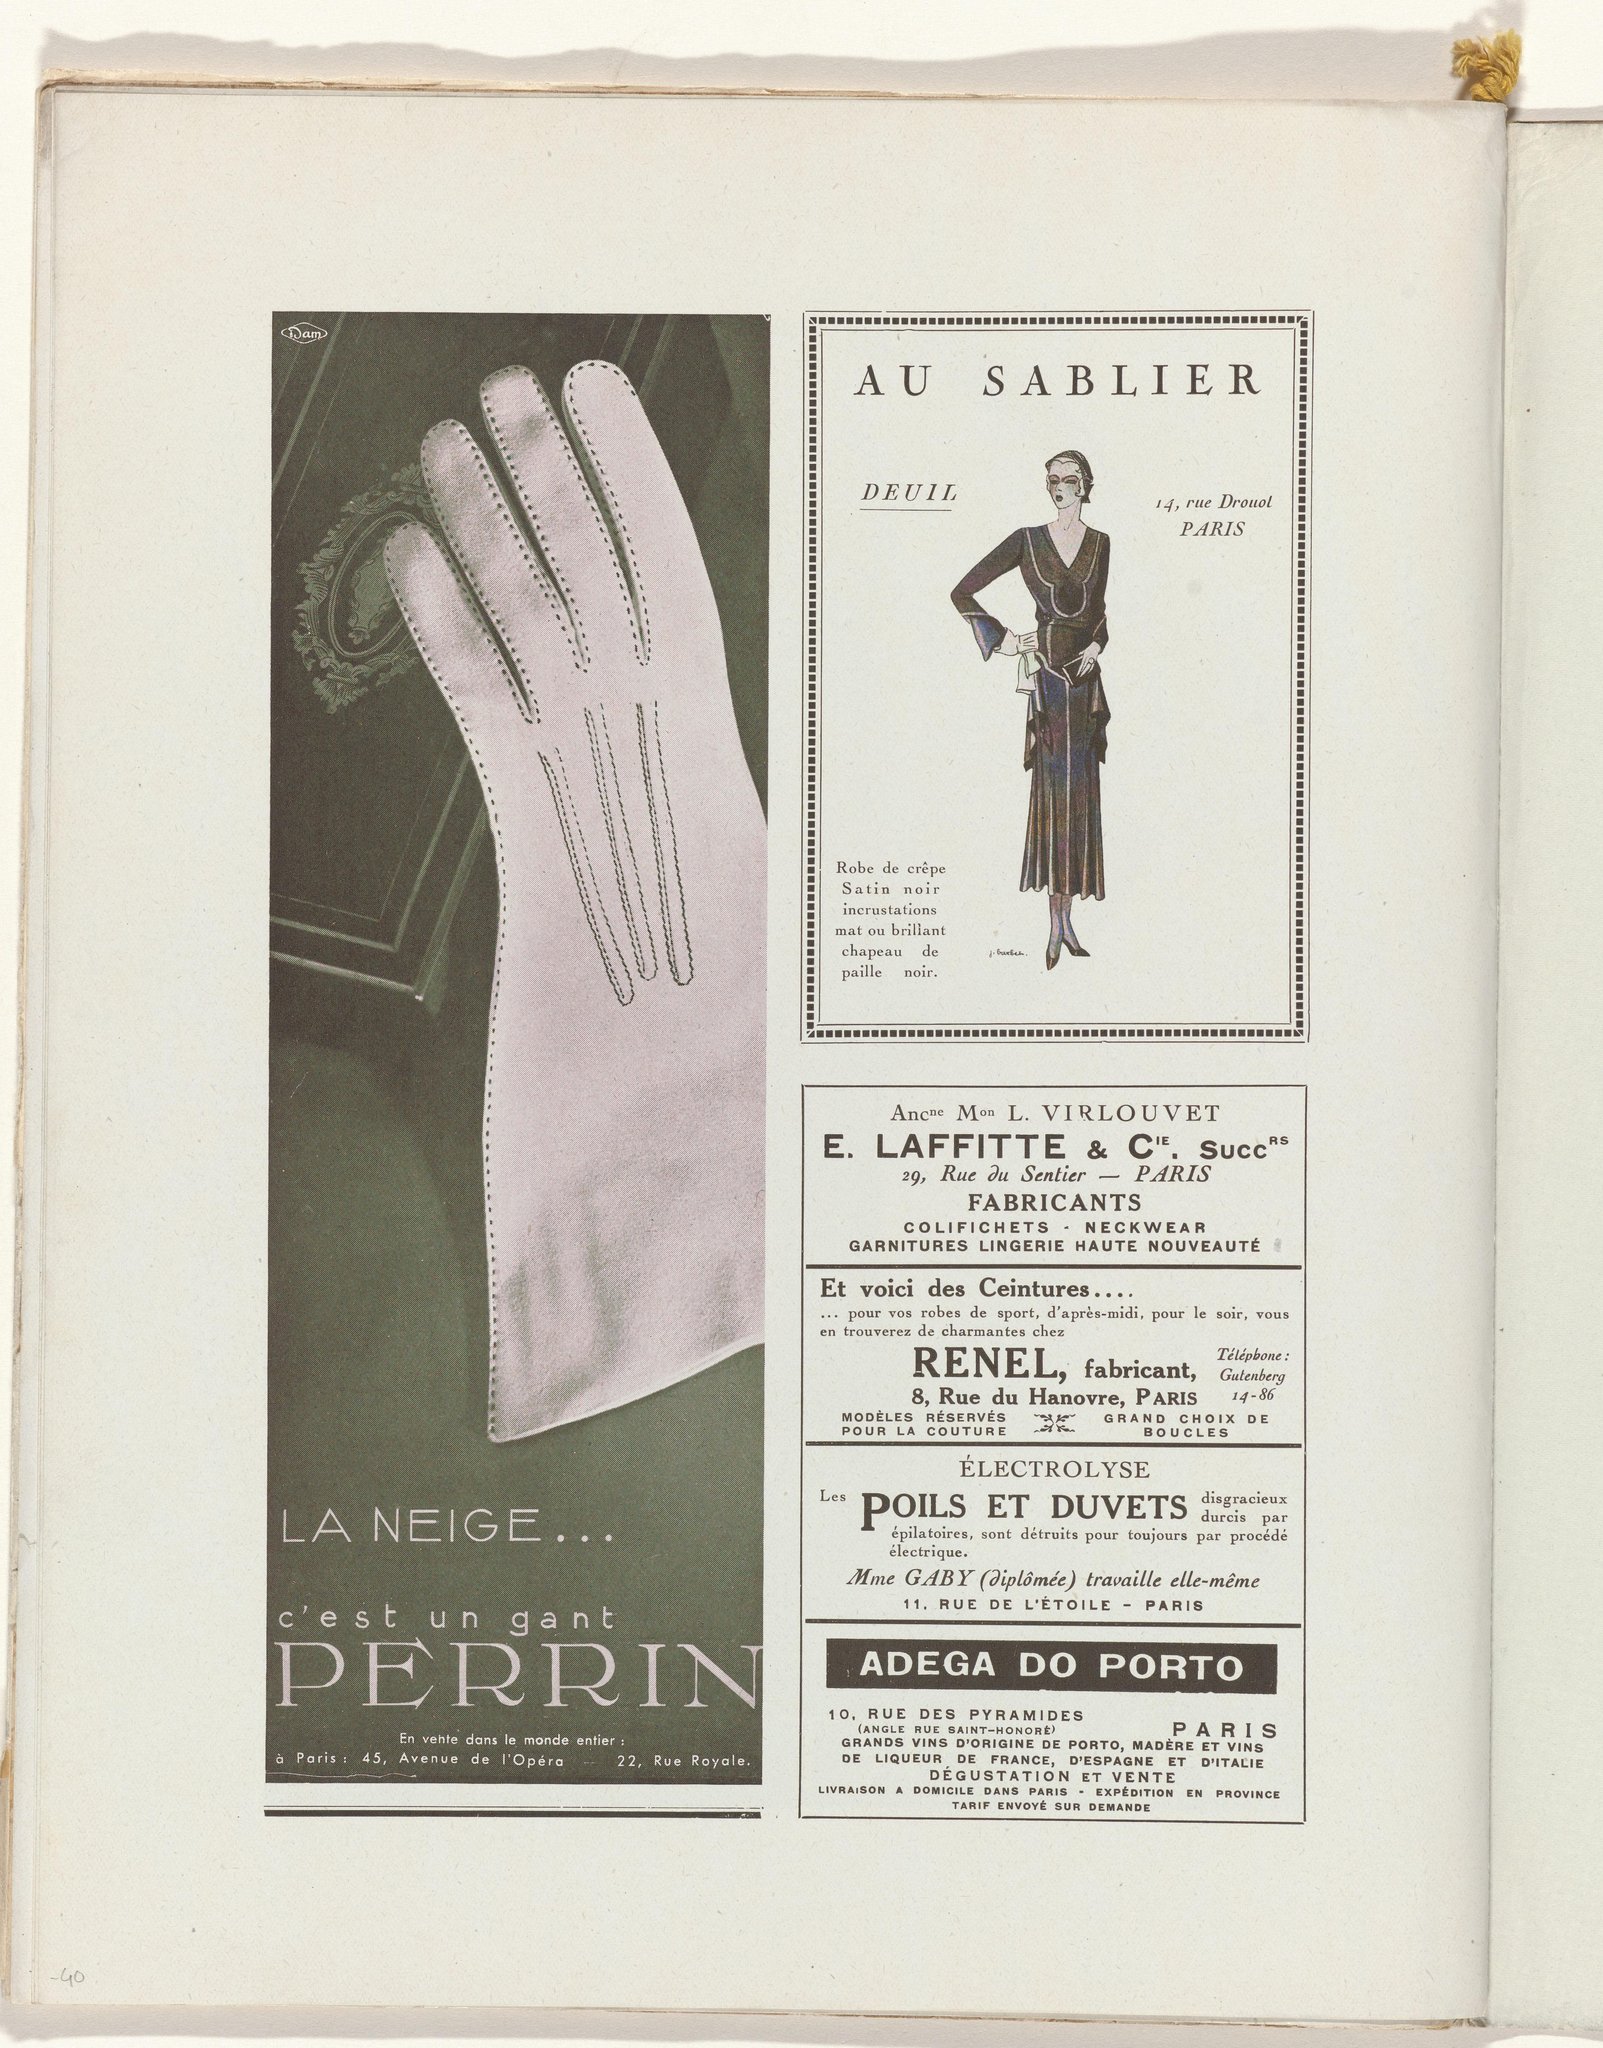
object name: magazine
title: Art - Goût - Beauté, Feuillets de l' élégance féminine, Mai 1931, No. 129, 11e Année, p. 40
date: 1931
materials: paper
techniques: photography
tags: gloves, mittens (short gloves) (+ women's clothes), fashion plates, dress, gown (+ women's clothes)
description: Advertenties voor handschoenen en andere producten. Pagina uit het modetijdschrift Art-Goût-Beauté (1920-1933).